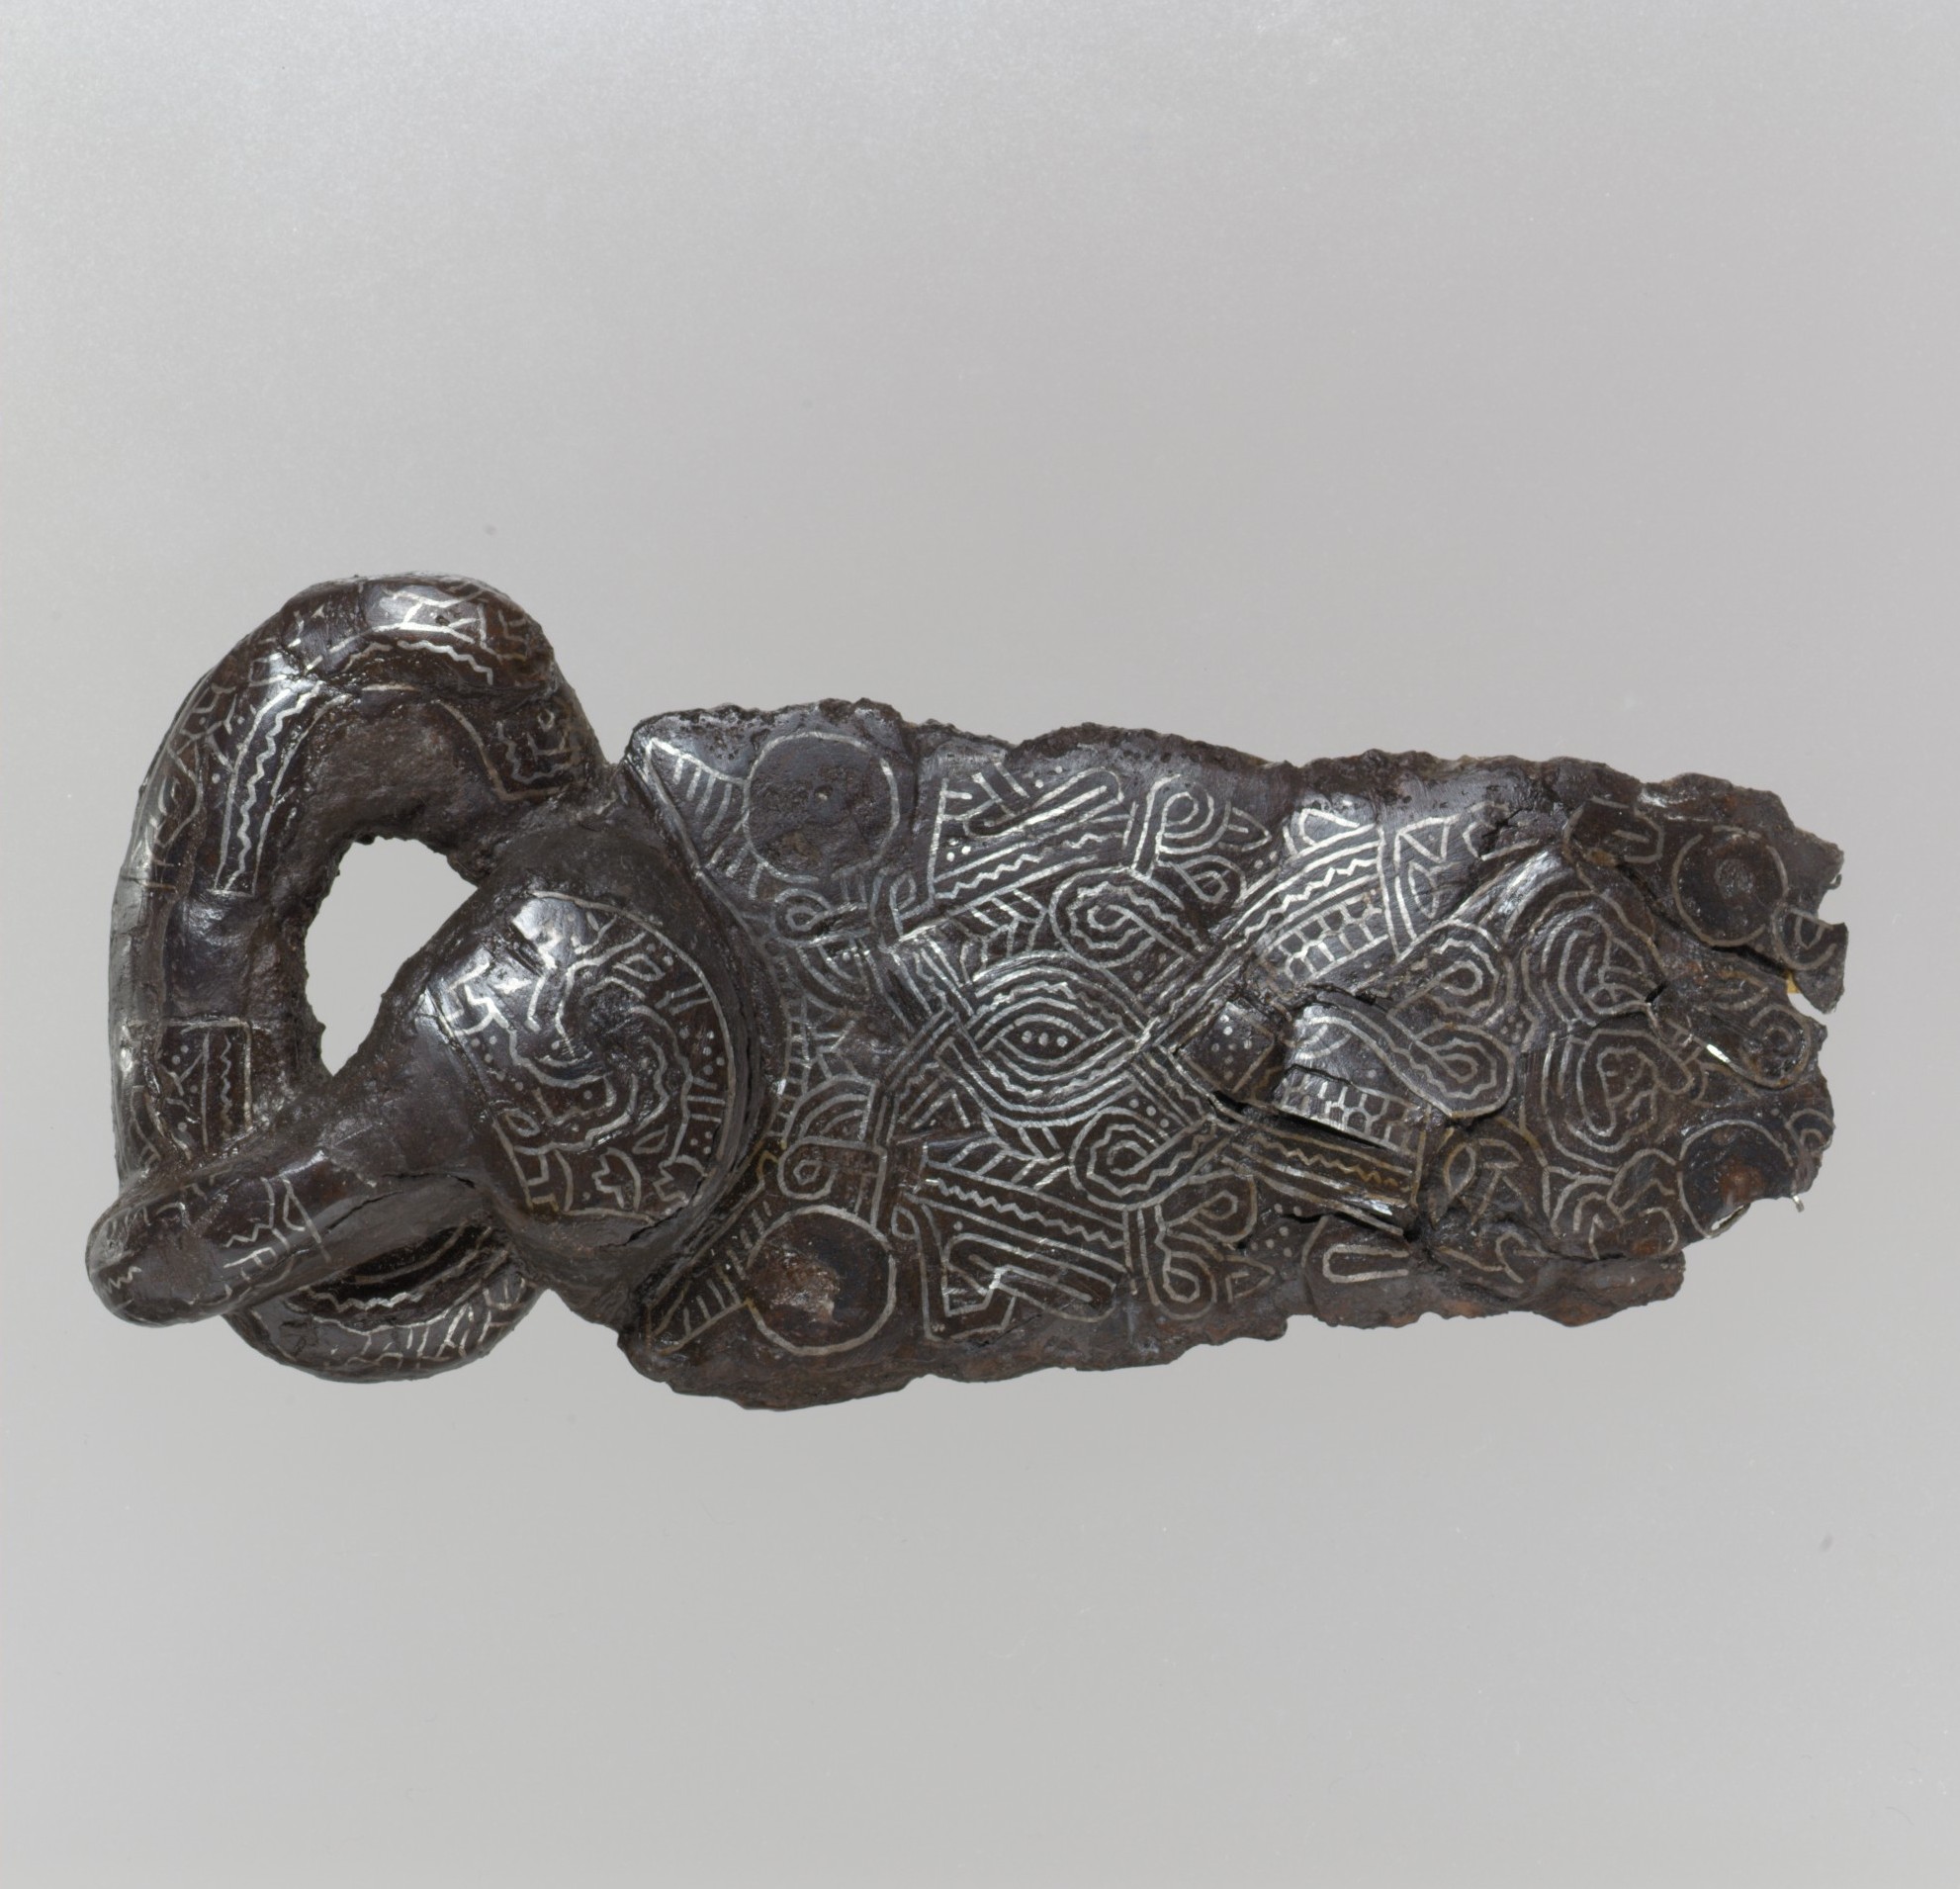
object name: belt buckle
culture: frankish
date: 501-700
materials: iron, silver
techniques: inlay